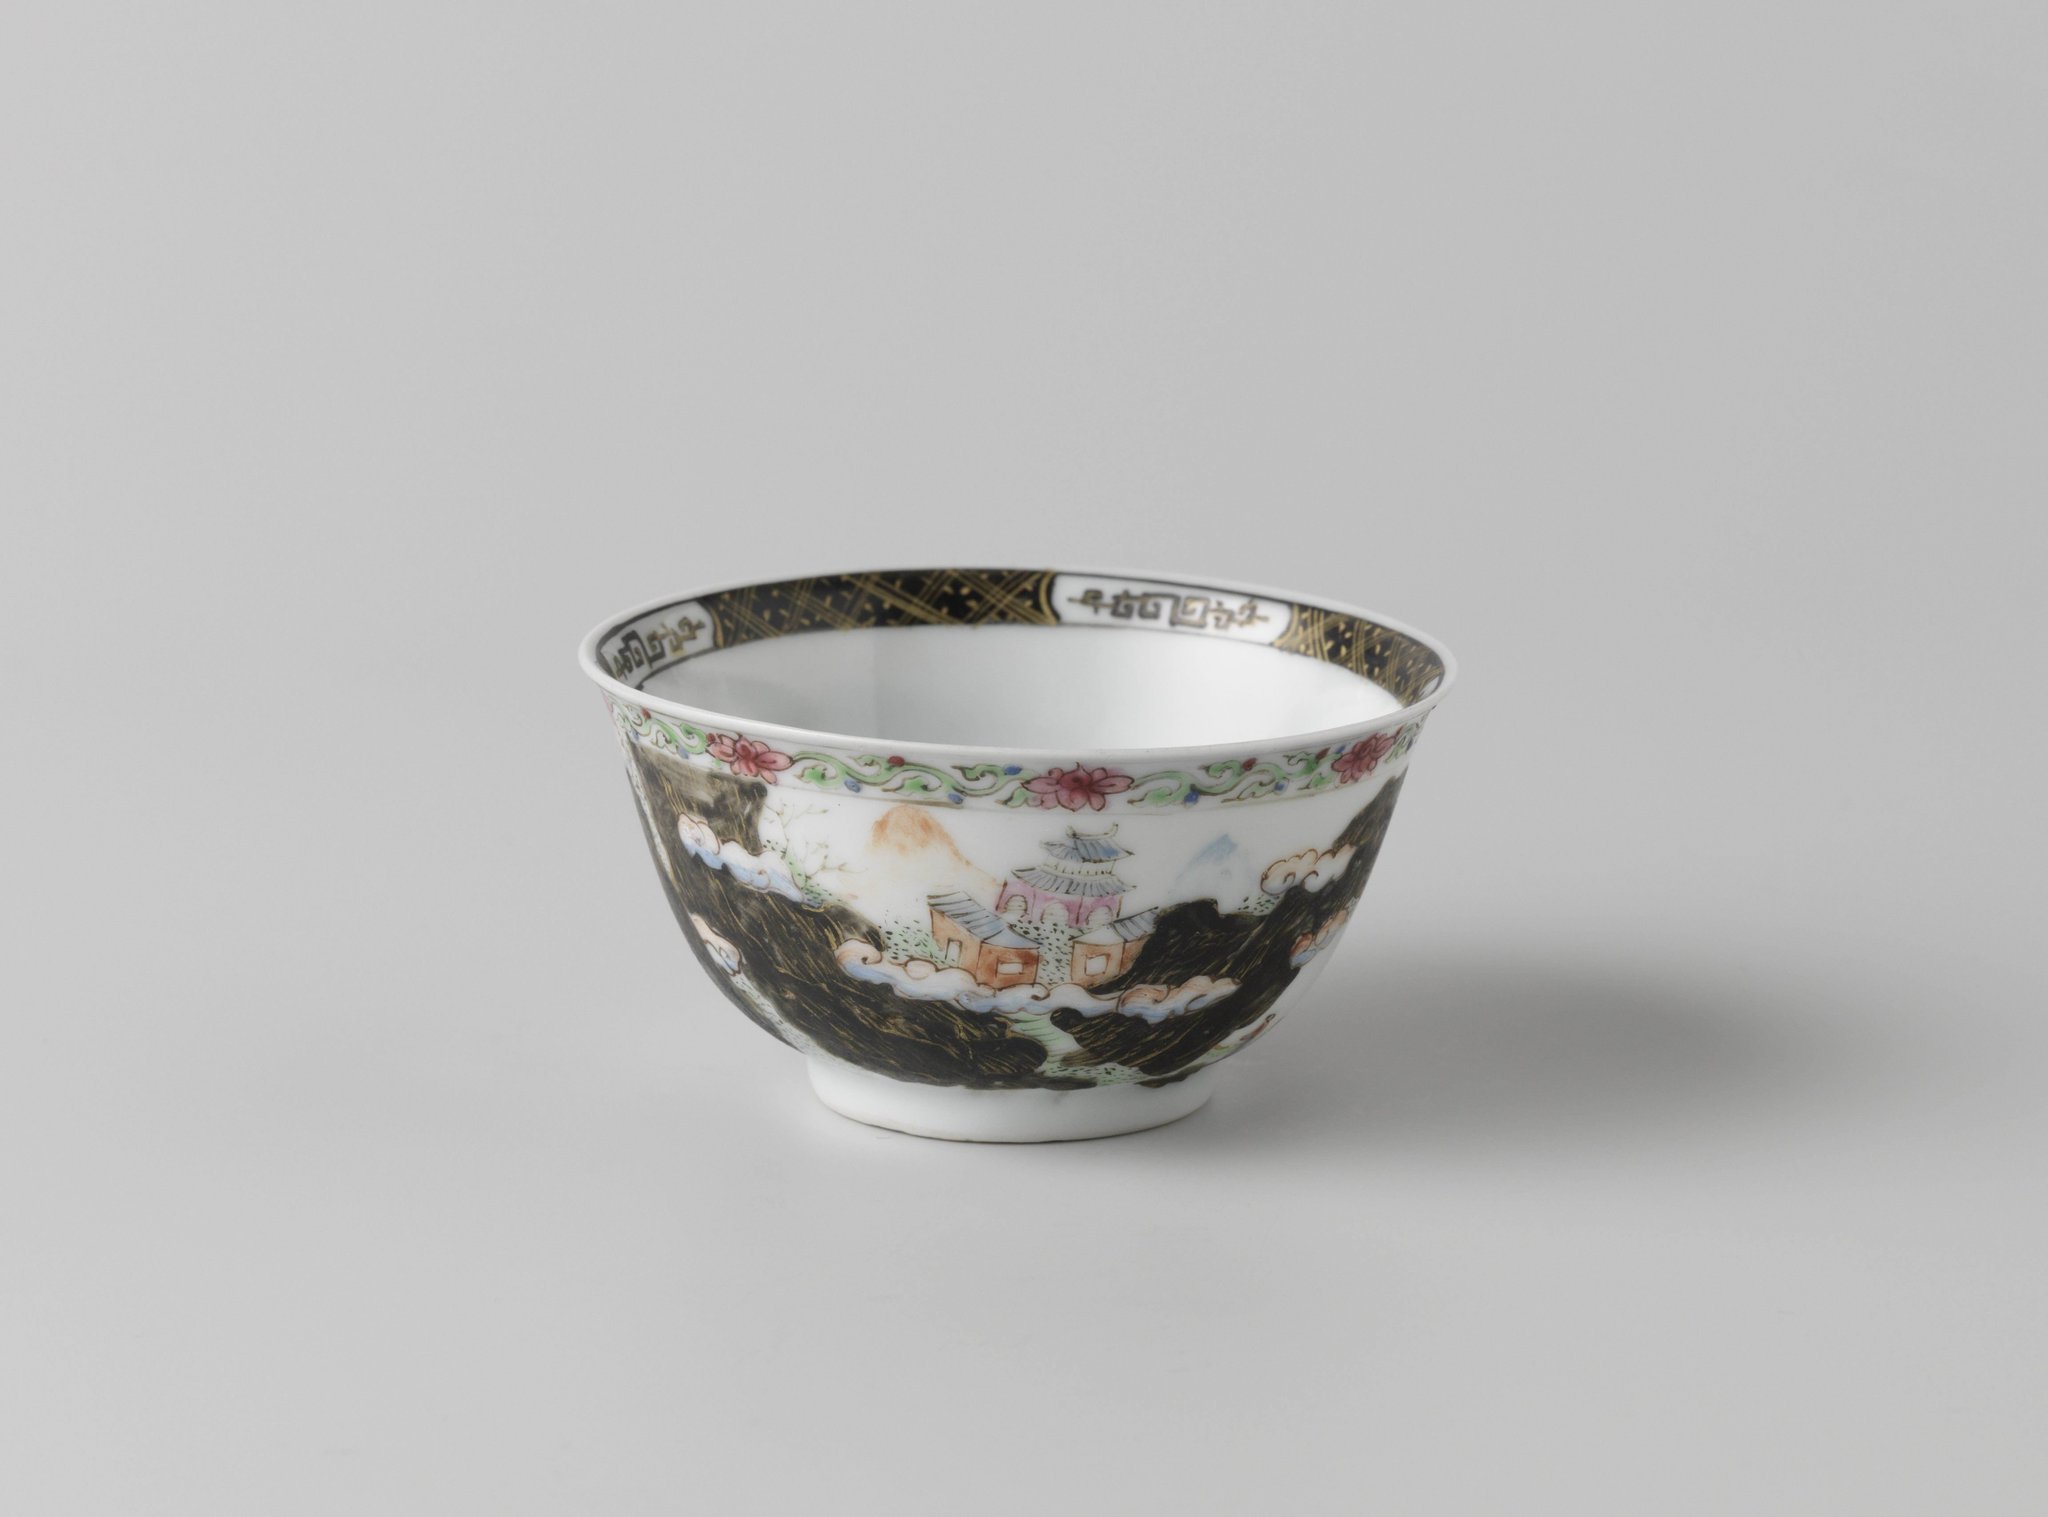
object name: cup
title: Bell-shaped cup with a mountainous landscape with pavilion, river and trees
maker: Anonymous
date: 1730-1740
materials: glaze, gold, paint, porcelain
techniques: firing, gilding, turning, vitrification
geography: china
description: Klokvormige kop van porselein, beschilderd op het glazuur in blauw, rood, roze, groen, zwart en goud. Een berglandschap met paviljoen, een rivier, bomen en mensen op een brug afgebeeld; op de wand twee banden: één met lotusranken en één met servetwerk afgewisseld met een cartouche met hoekige ranken. Famille rose.